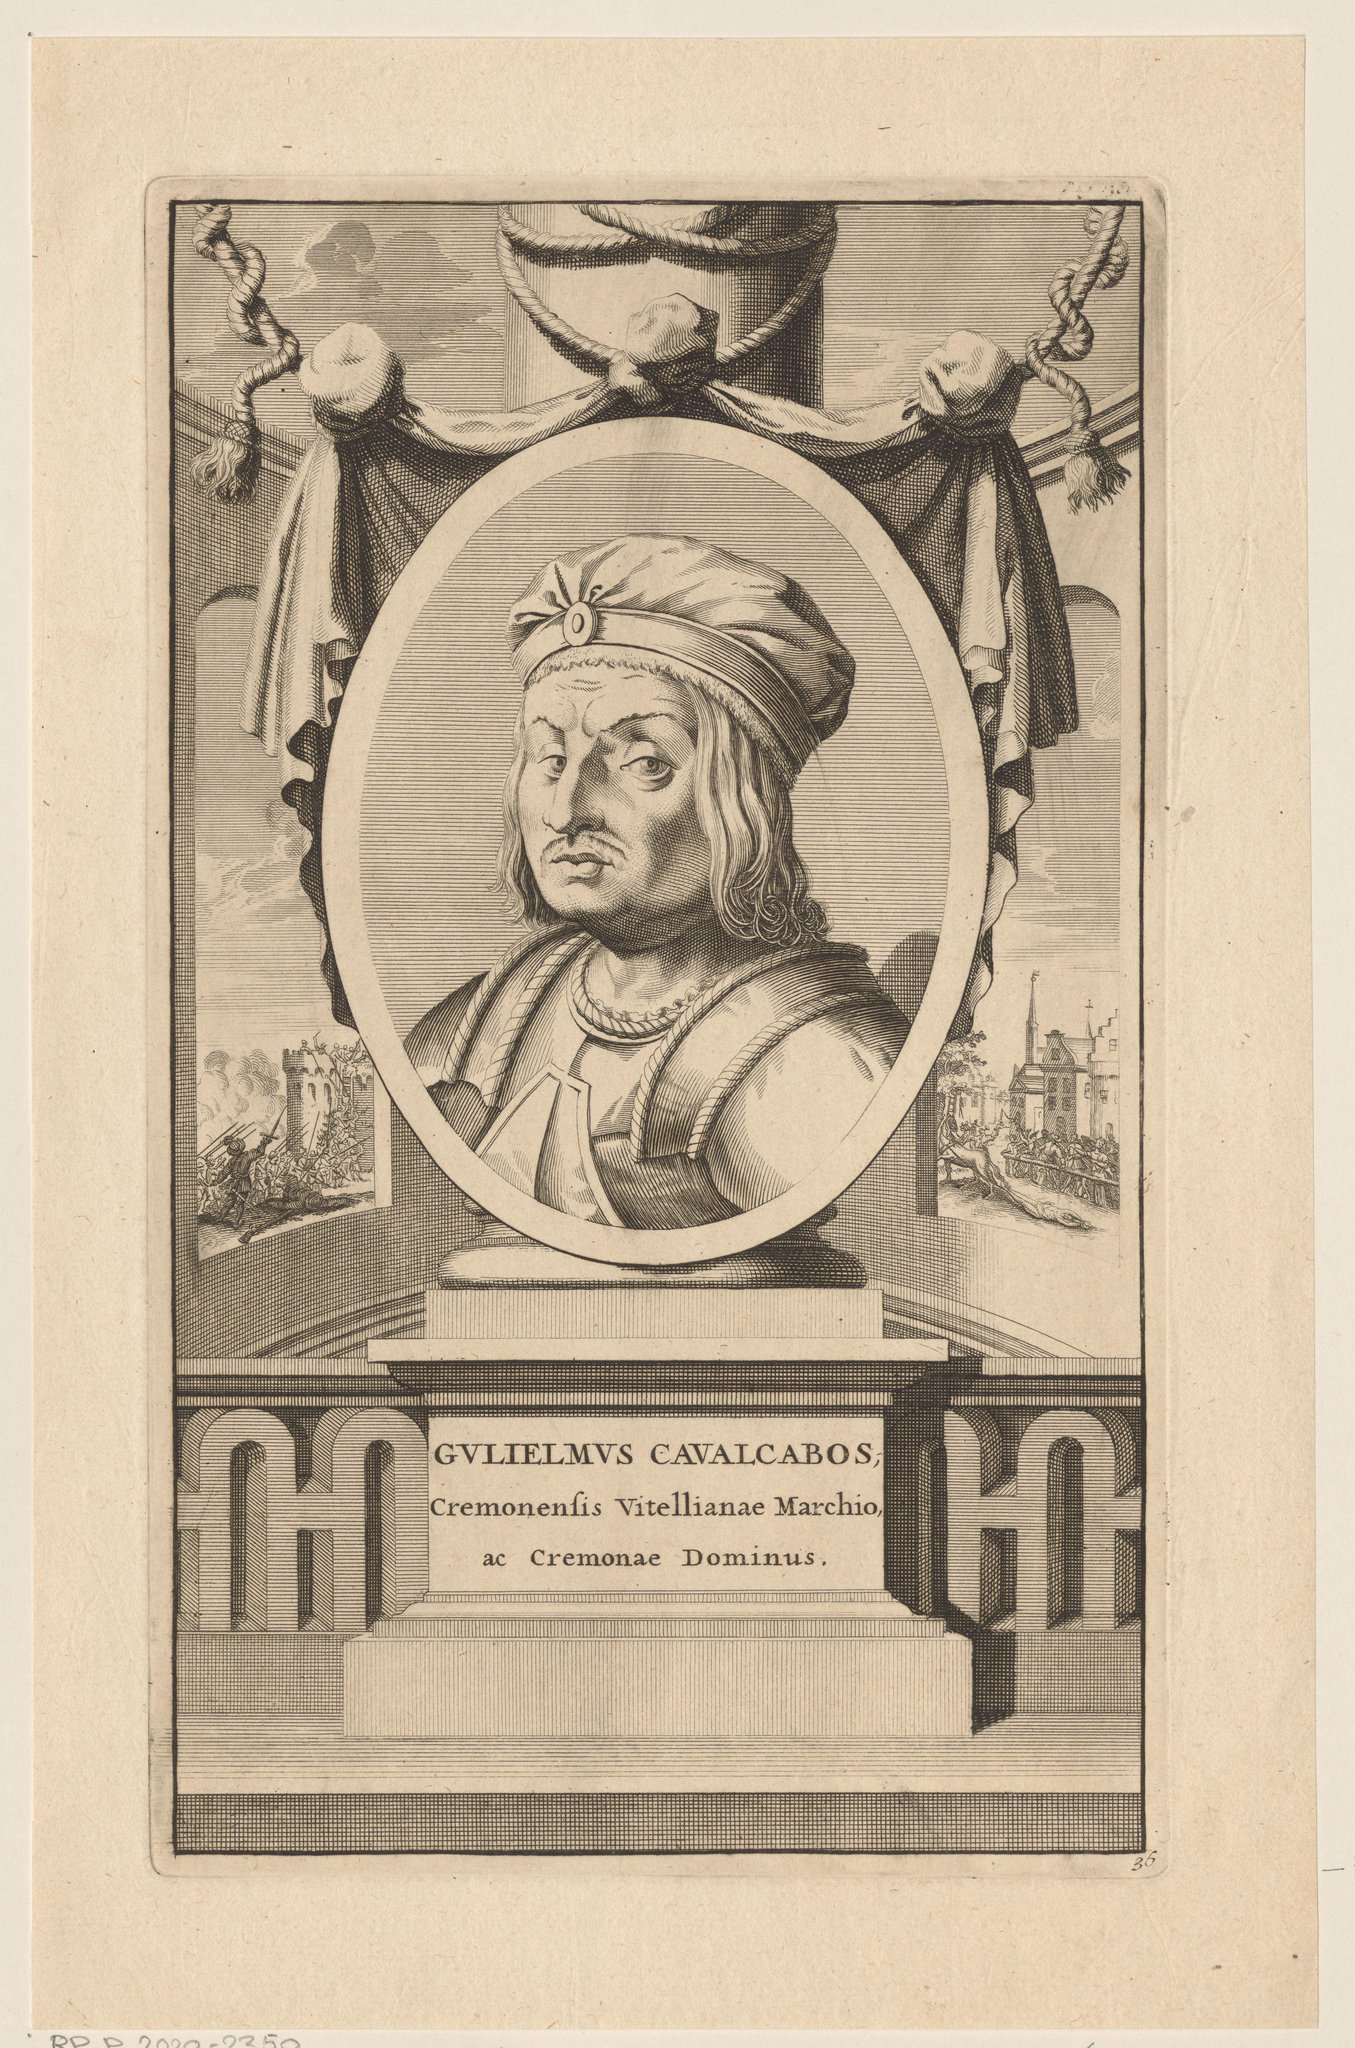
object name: print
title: Portret van Guglielmo Cavalcabò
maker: hillebrand van der aa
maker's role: painter, print maker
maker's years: 1659-1721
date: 1710-1720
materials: paper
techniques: engraving, etching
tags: historical persons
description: Prent waarschijnlijk uit: Principium et illustrium quorundam virorum (...). Leiden: Pieter van der Aa, [1710-1720].